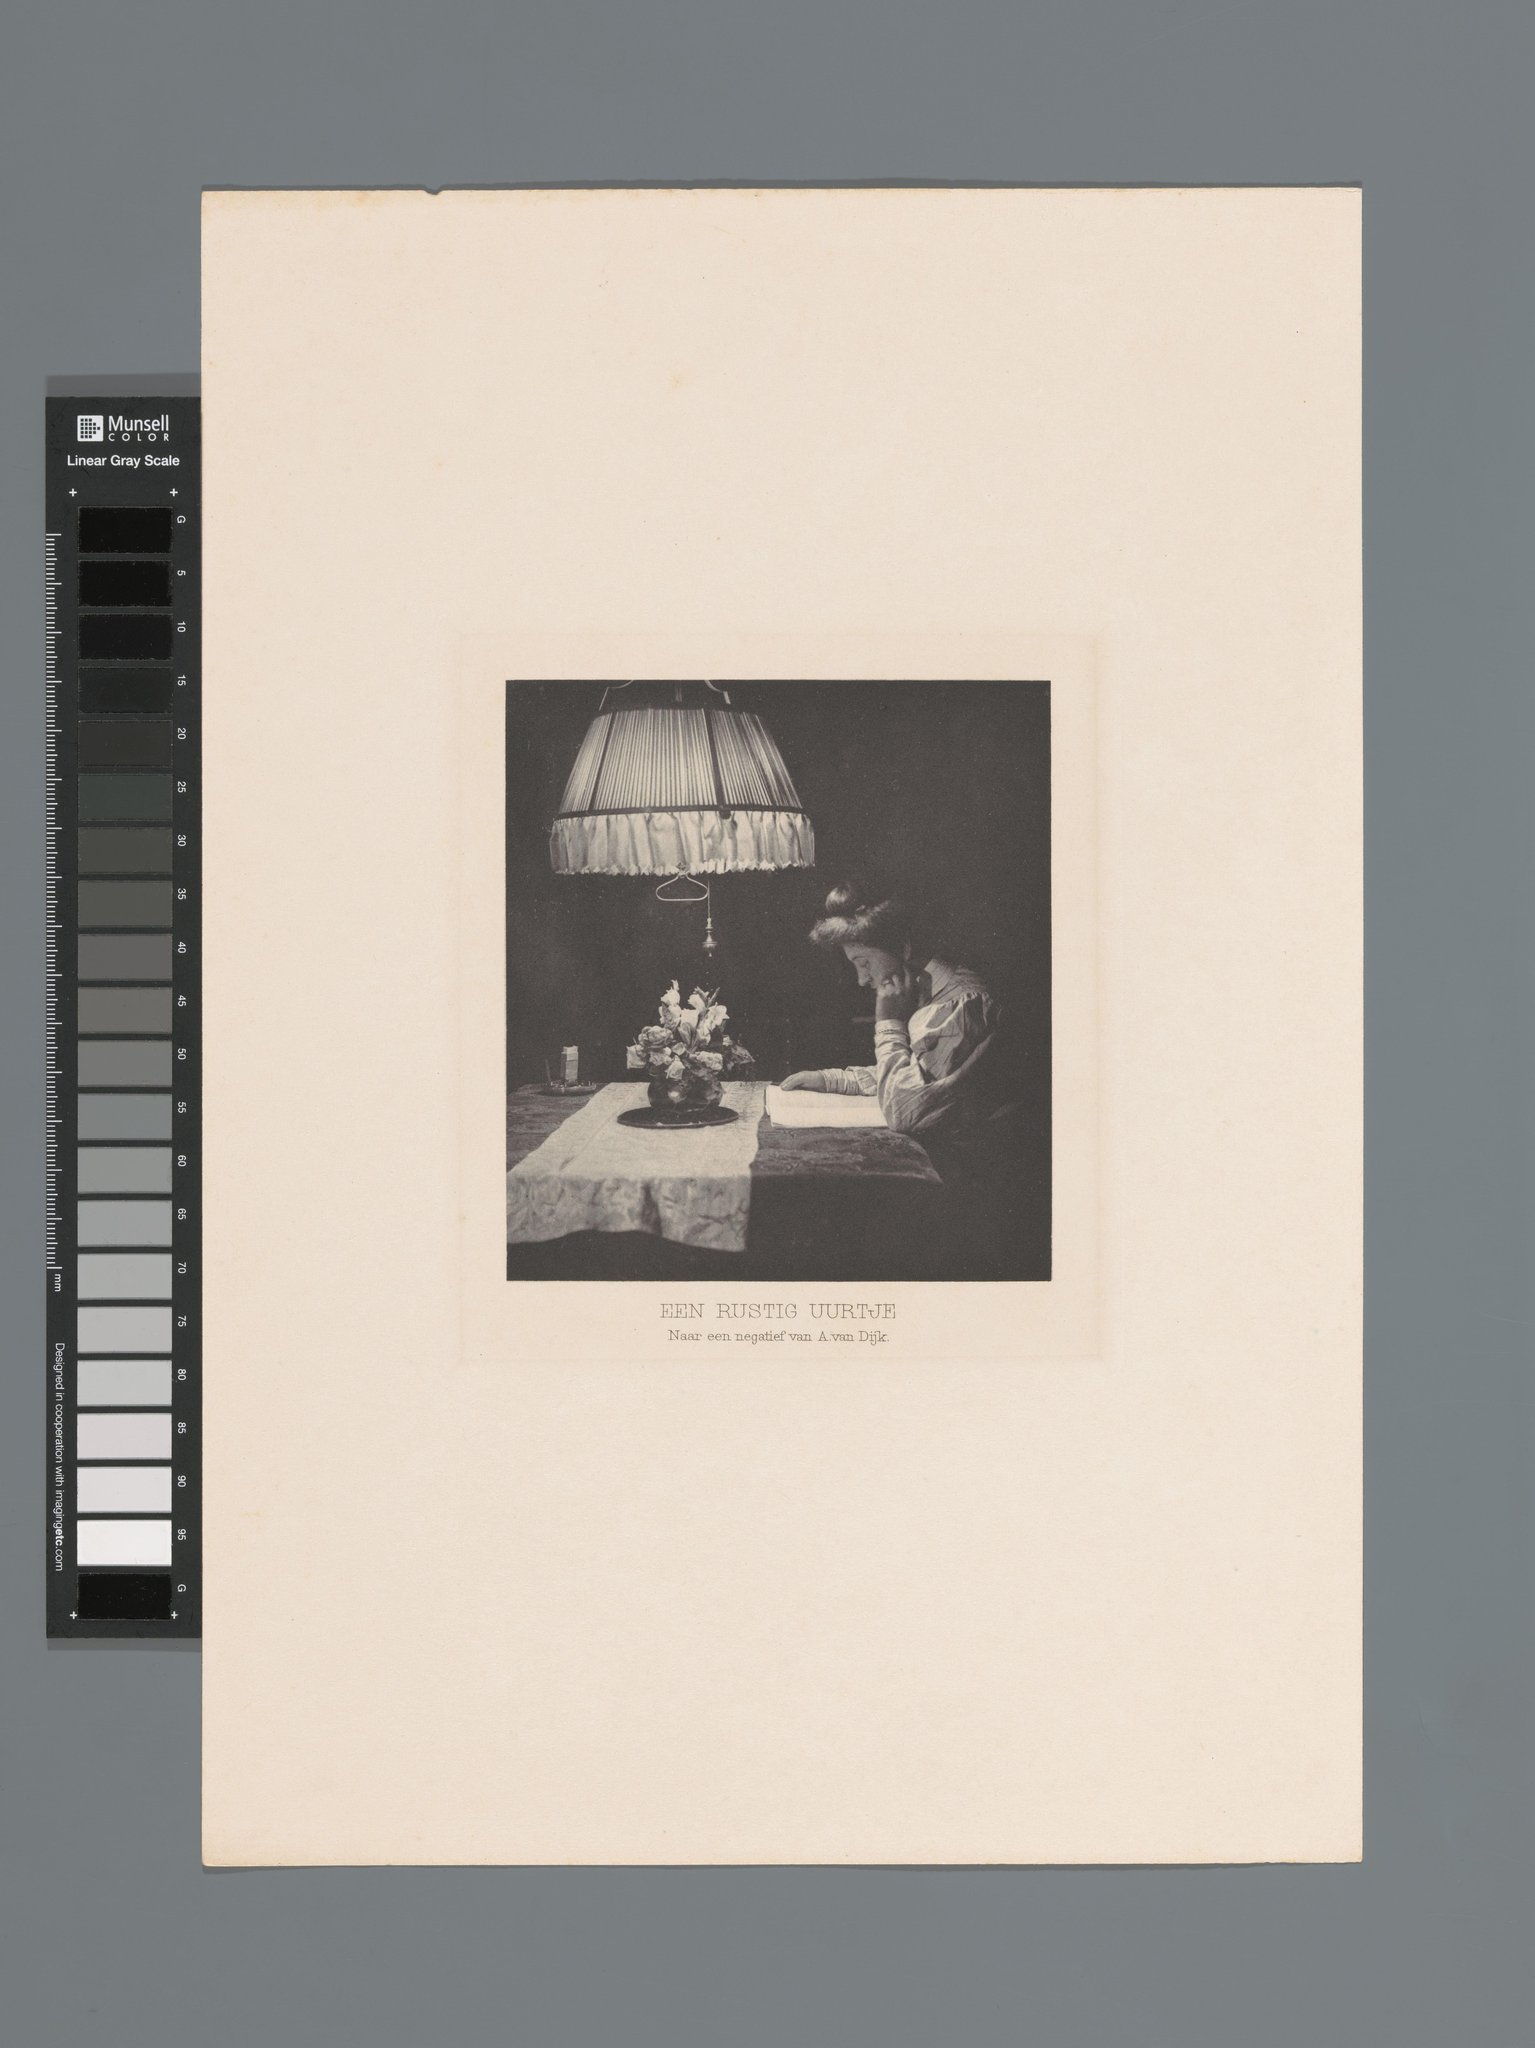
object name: photomechanical print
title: Een rustig uurtje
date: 1901-1906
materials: paper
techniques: photoaquatint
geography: netherlands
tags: adult woman, reading